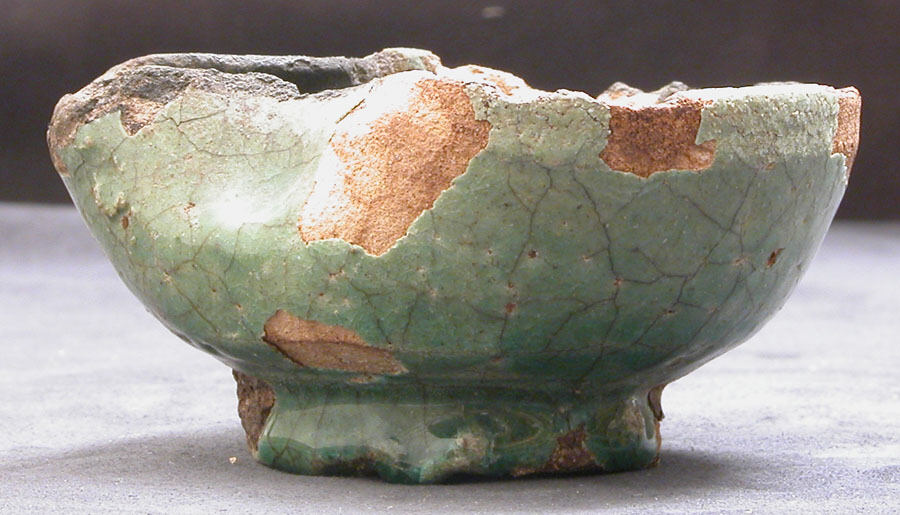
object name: lamp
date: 1301-1400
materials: earthenware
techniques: glazing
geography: syria